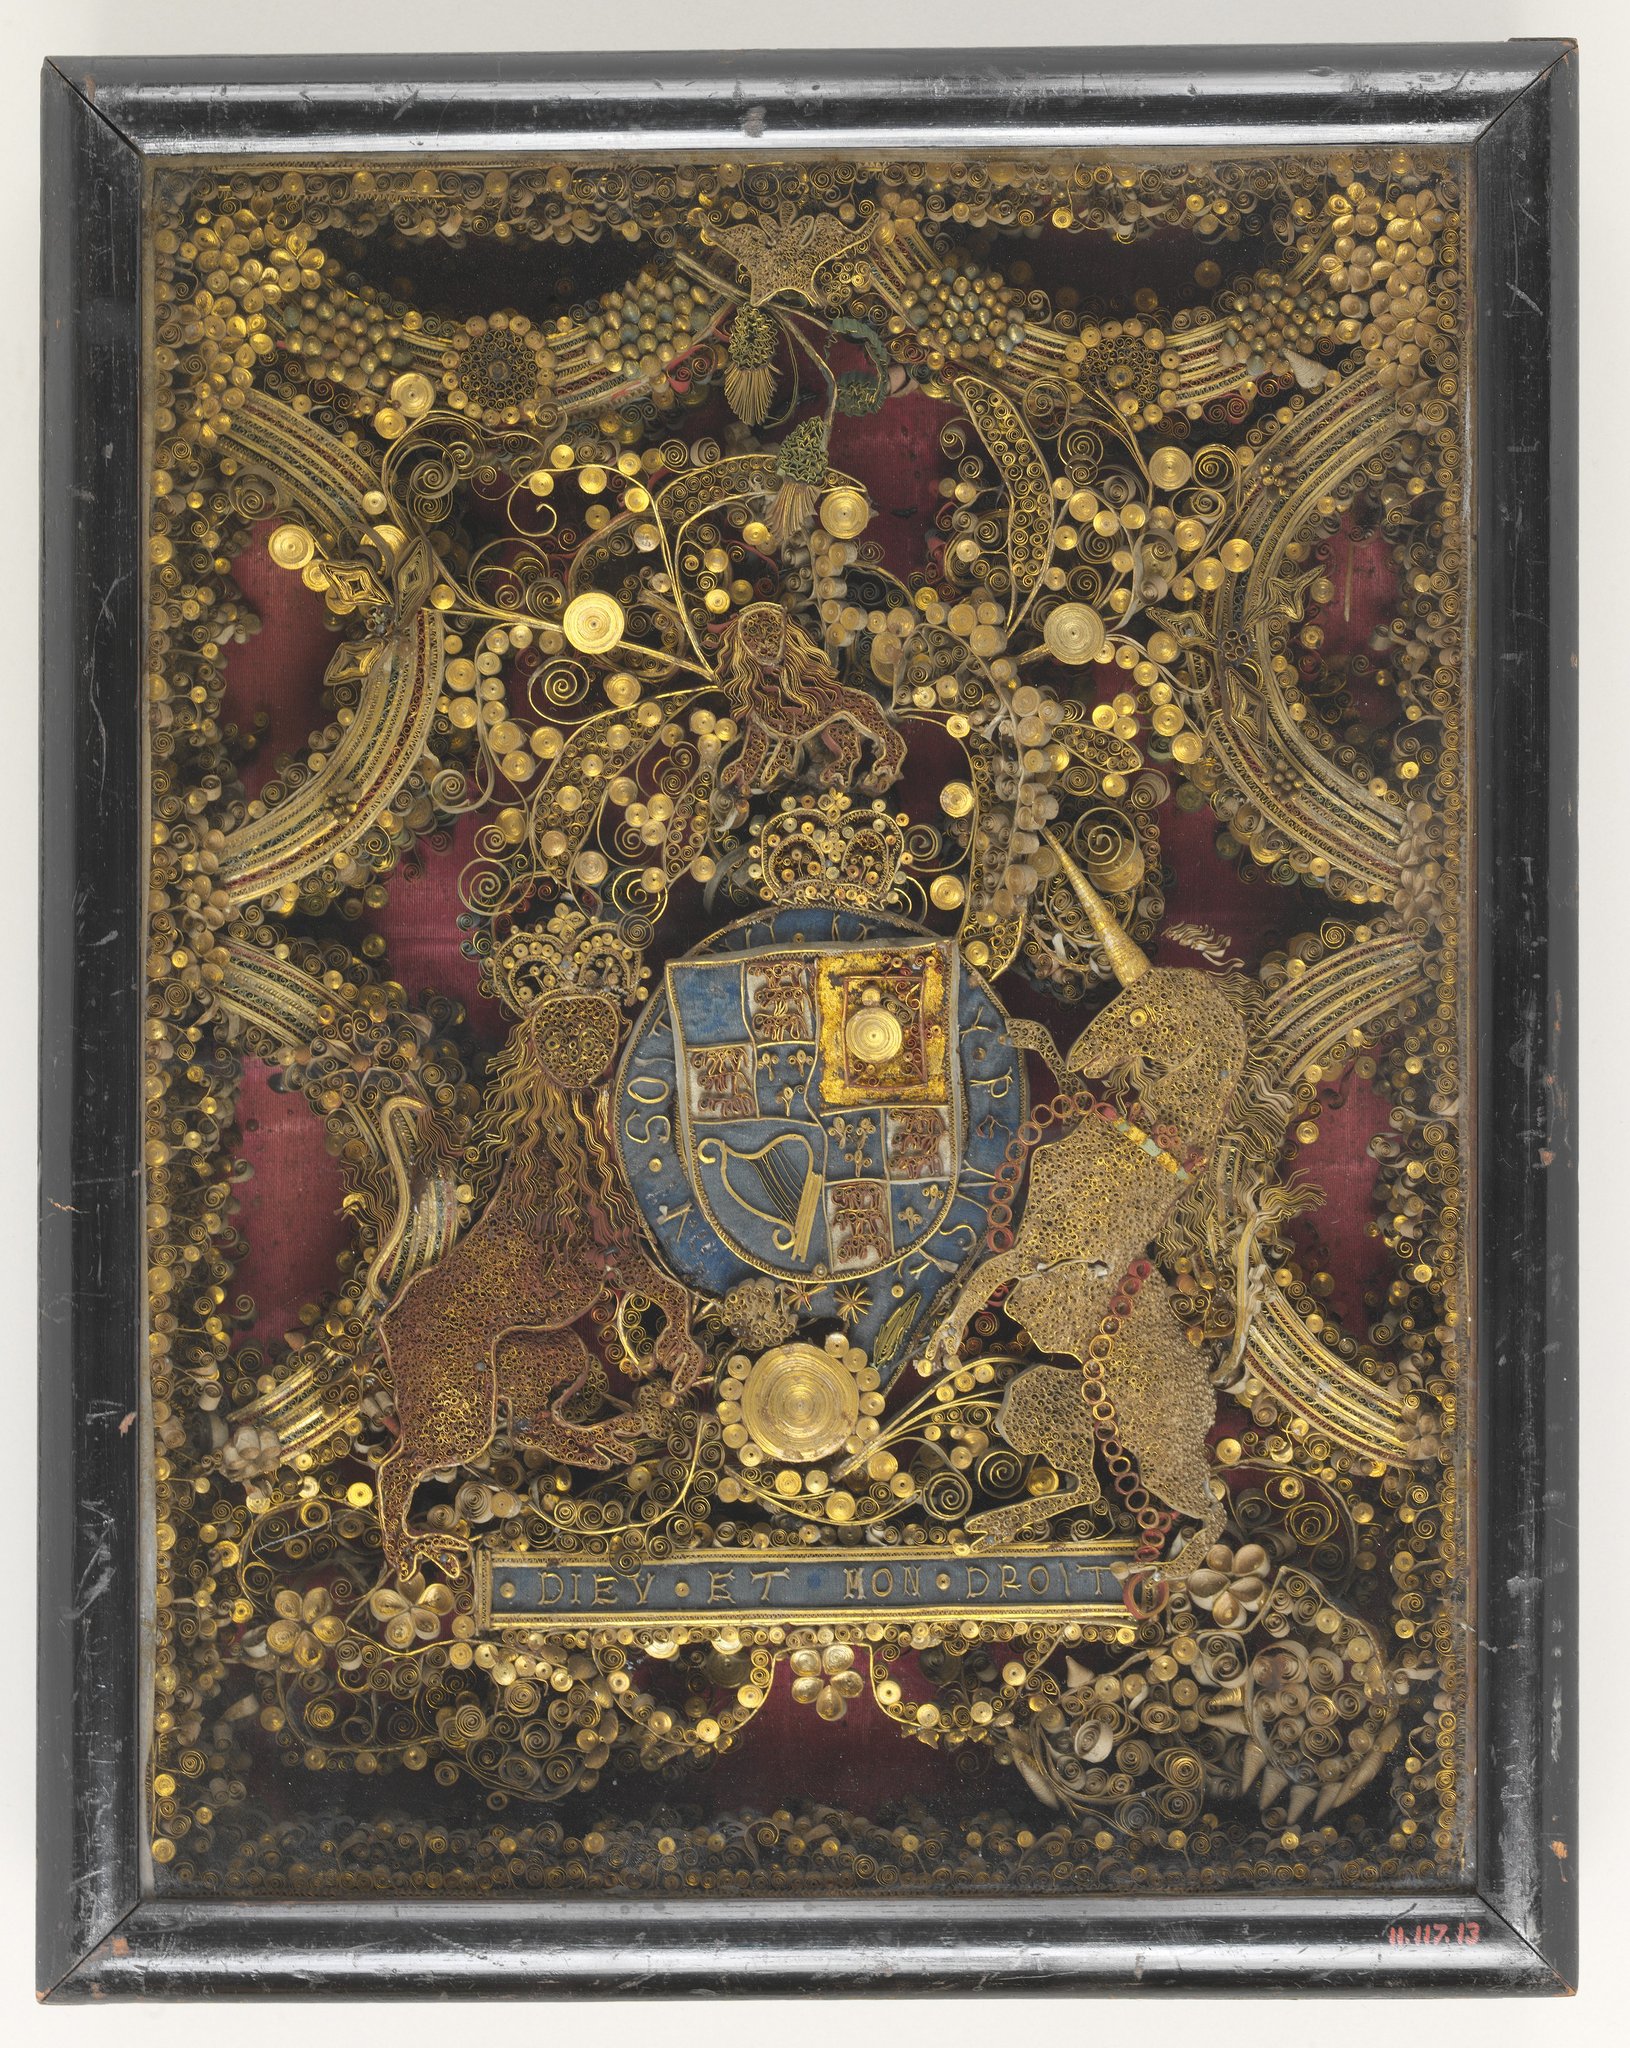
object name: coat of arm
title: Royal Arms of Great Britain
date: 1660-1688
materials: cardboard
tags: unicorns,coat of arms